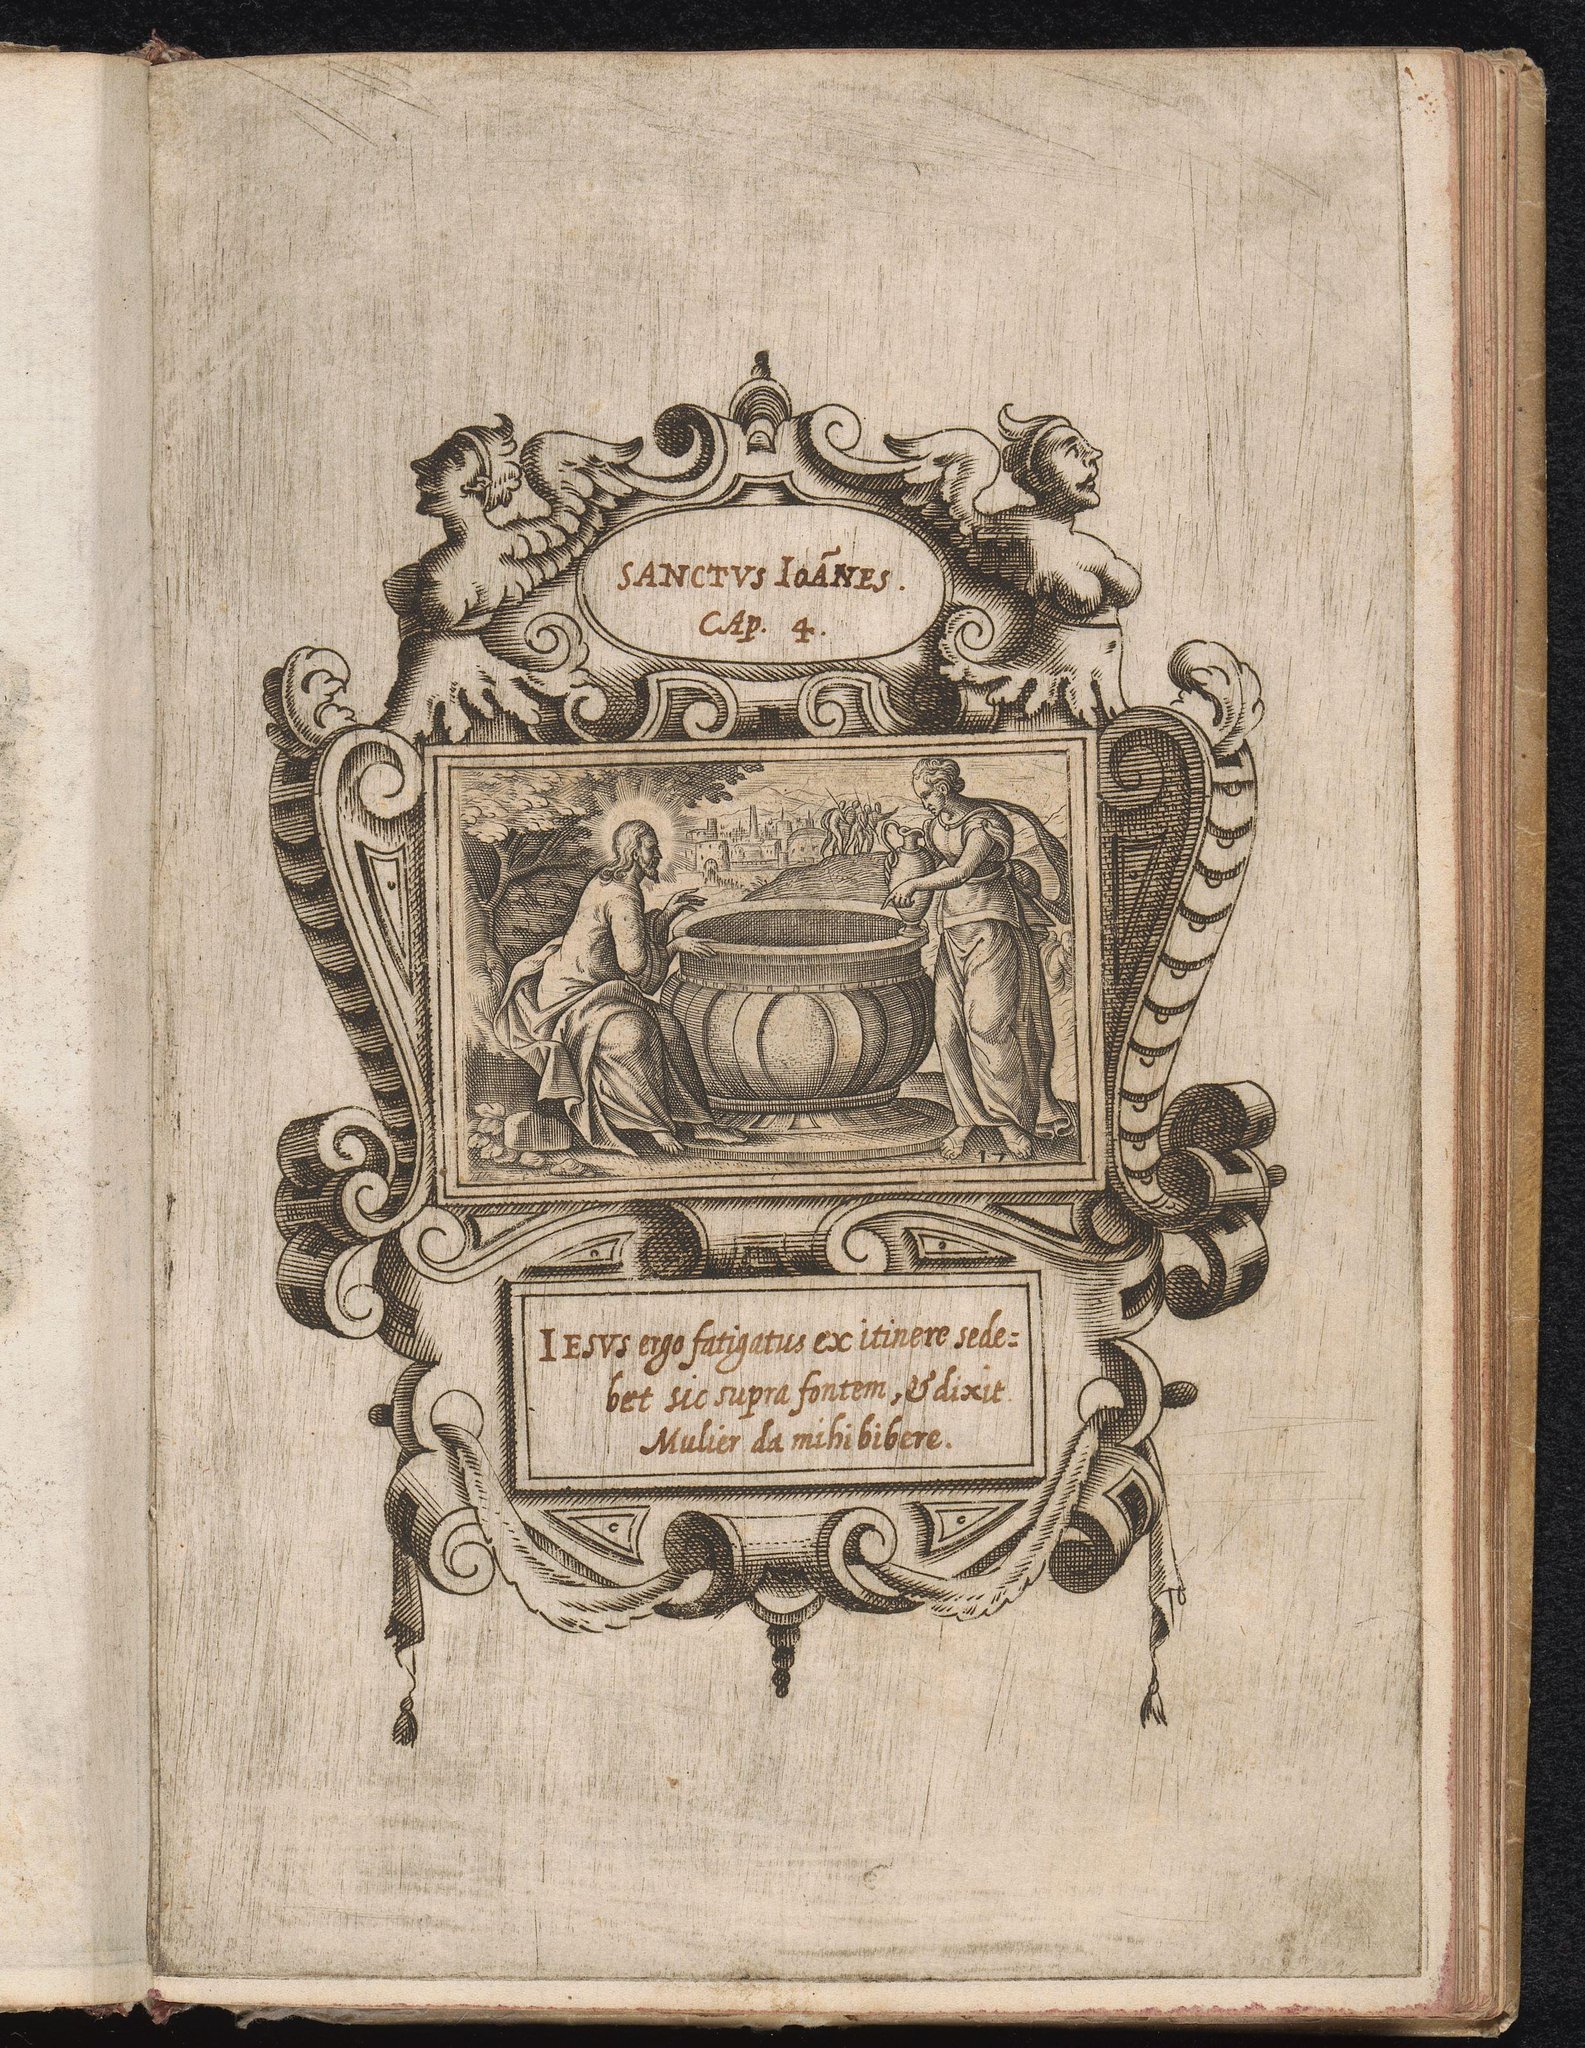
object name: print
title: Het leven van Christus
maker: monogrammist hsd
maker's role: print maker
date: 1570-1610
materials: paper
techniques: engraving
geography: antwerp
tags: christ and the woman of samaria: sitting at jacob's well he asks her for a drink from her jug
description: Christus en de Samaritaanse vrouw. Onderdeel van een prentalbum met titelprent en 56 scènes uit het Nieuwe Testament. Elke voorstelling gemonteerd in een gravure met ornamentele cartouches waarin een venster is gesneden en voorzien van handgeschreven bijbelpassages.